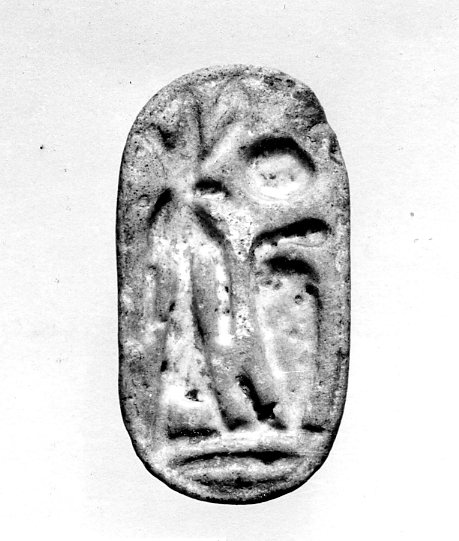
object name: seal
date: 1295-1070 BCE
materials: faience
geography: egypt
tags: hieroglyphs